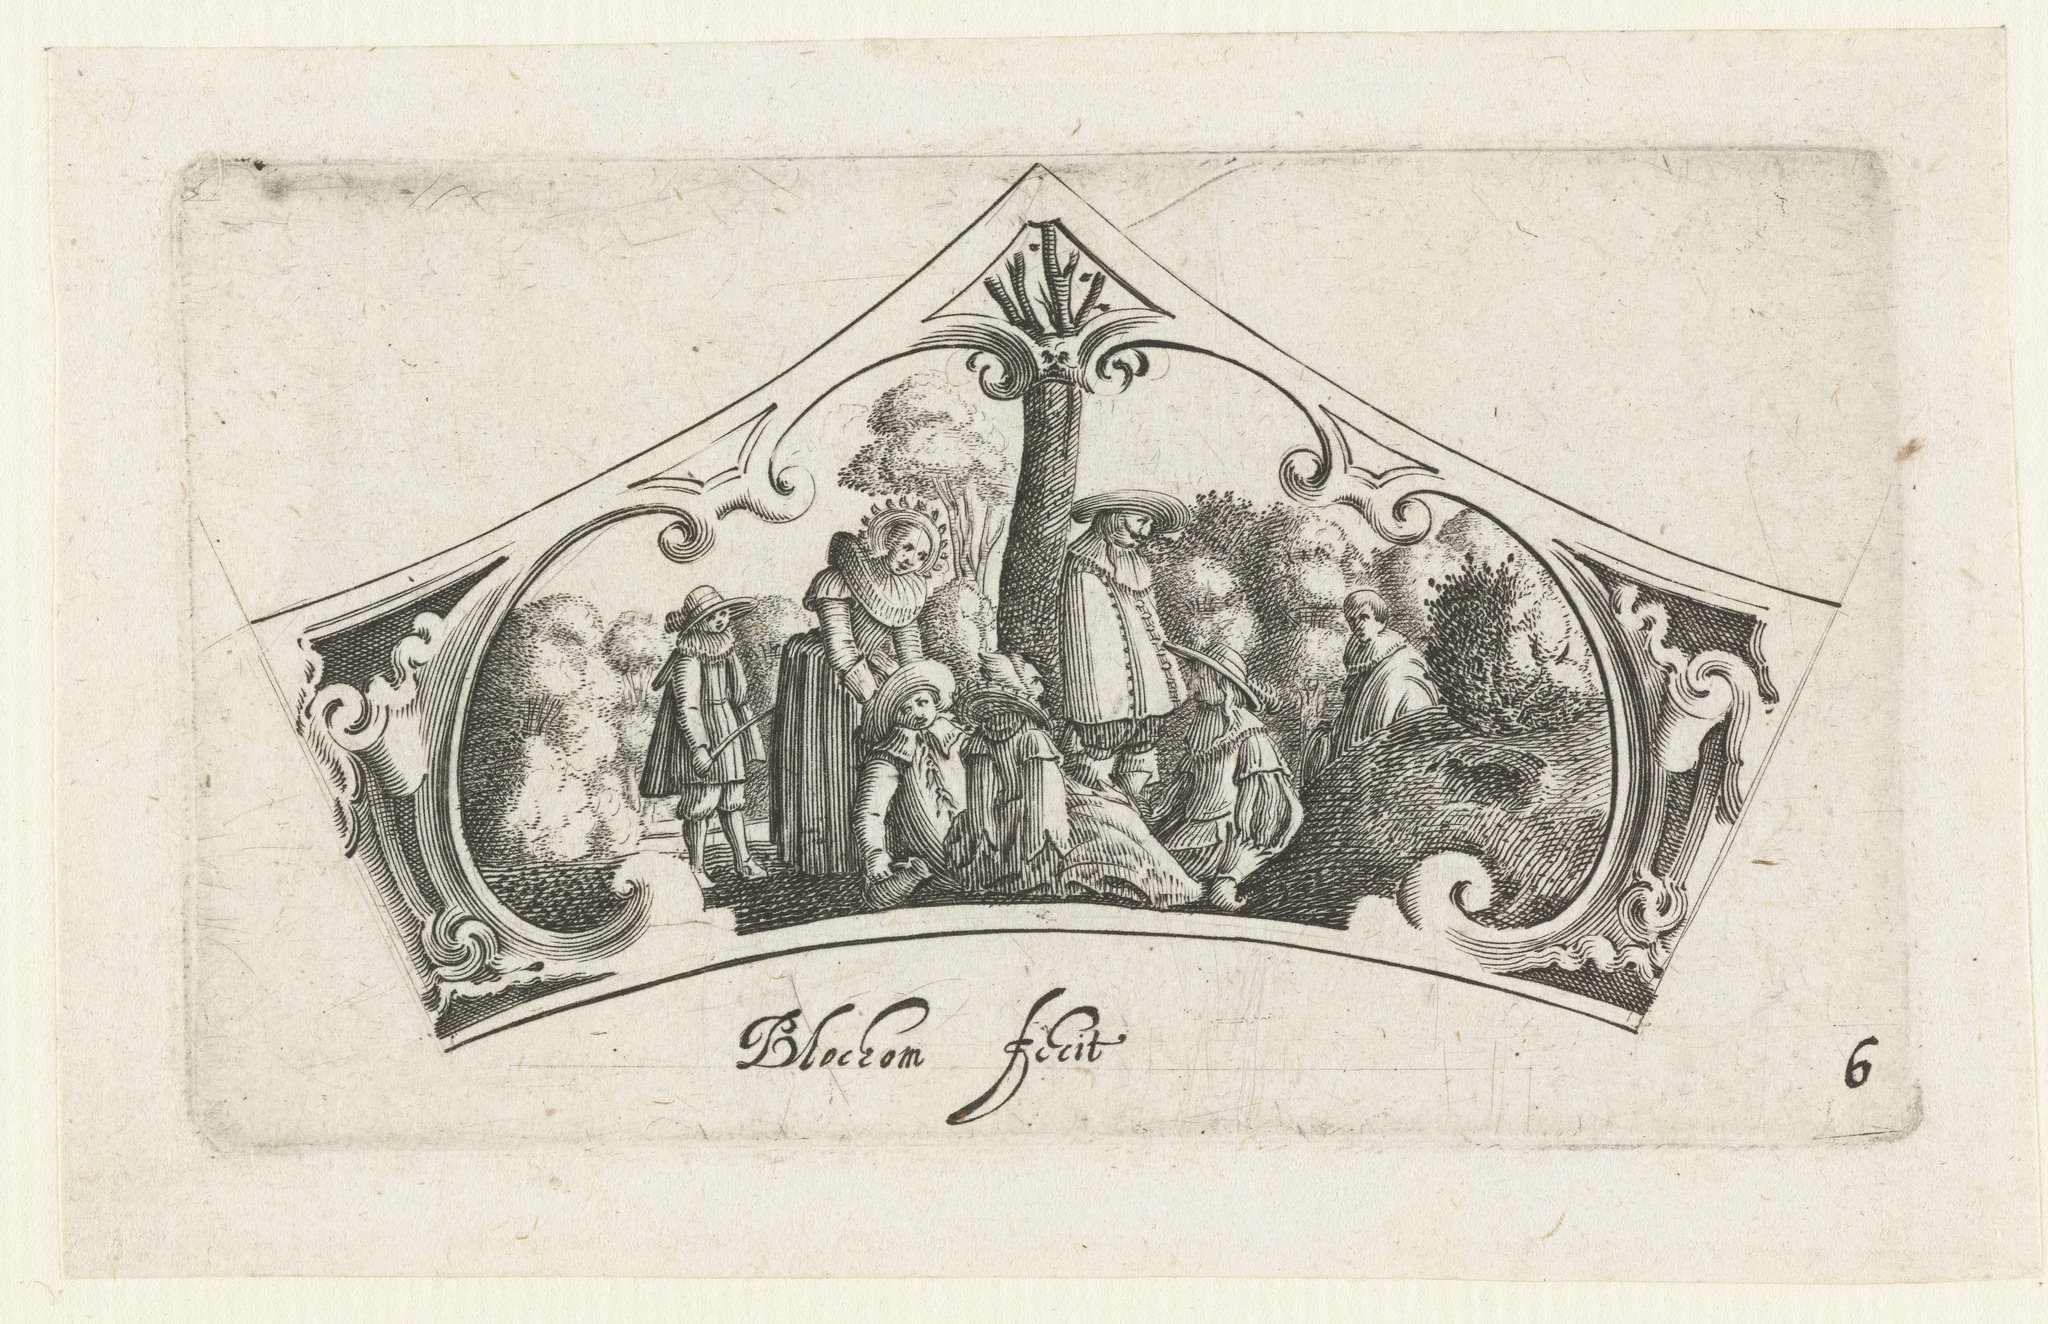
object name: print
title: Ontwerpen voor de rand van een achthoekige schotel, met scènes van het landleven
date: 1630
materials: paper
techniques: engraving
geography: amsterdam